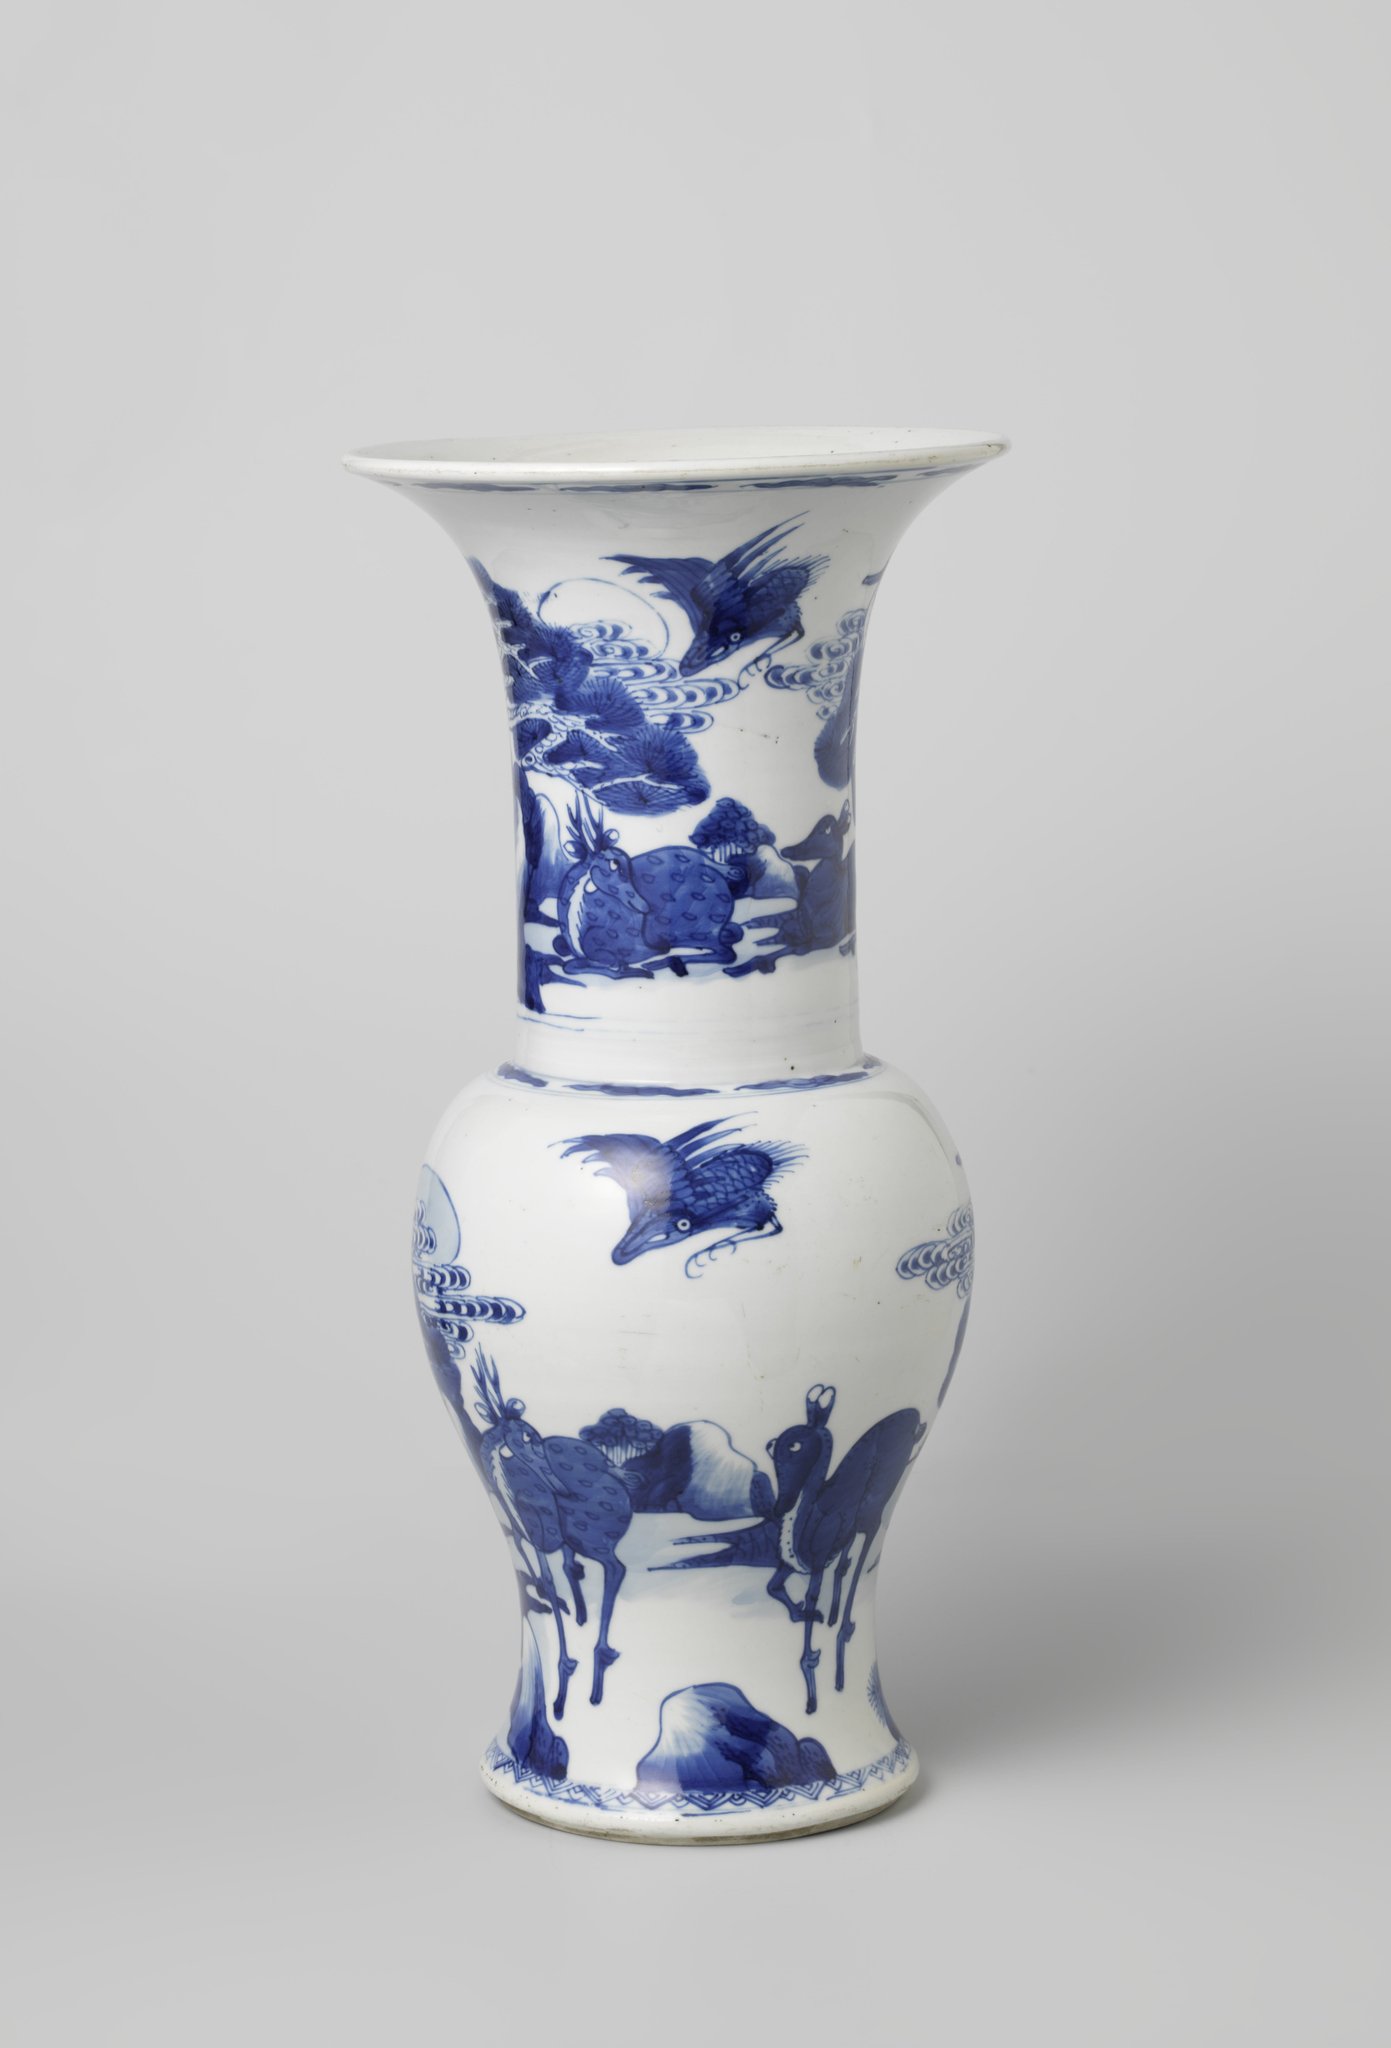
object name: vase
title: Baluster vase with deer and cranes in a water landscape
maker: Anonymous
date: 1675-1699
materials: cobalt, glaze, paint, porcelain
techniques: firing, turning, vitrification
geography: china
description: Balustervormige vaas van porselein met een trompetvormige mond, beschilderd in onderglazuur blauw. Op de wand een rivierlandschap met daarin twee herten, een vliegende kraanvogel en één op een tak van een pijnpoom. Op de hals dezelfde decoratie. De buitenrand met een band met wolkmotieven. De onderzijde met een dubbele cirkel. Blauw-wit.